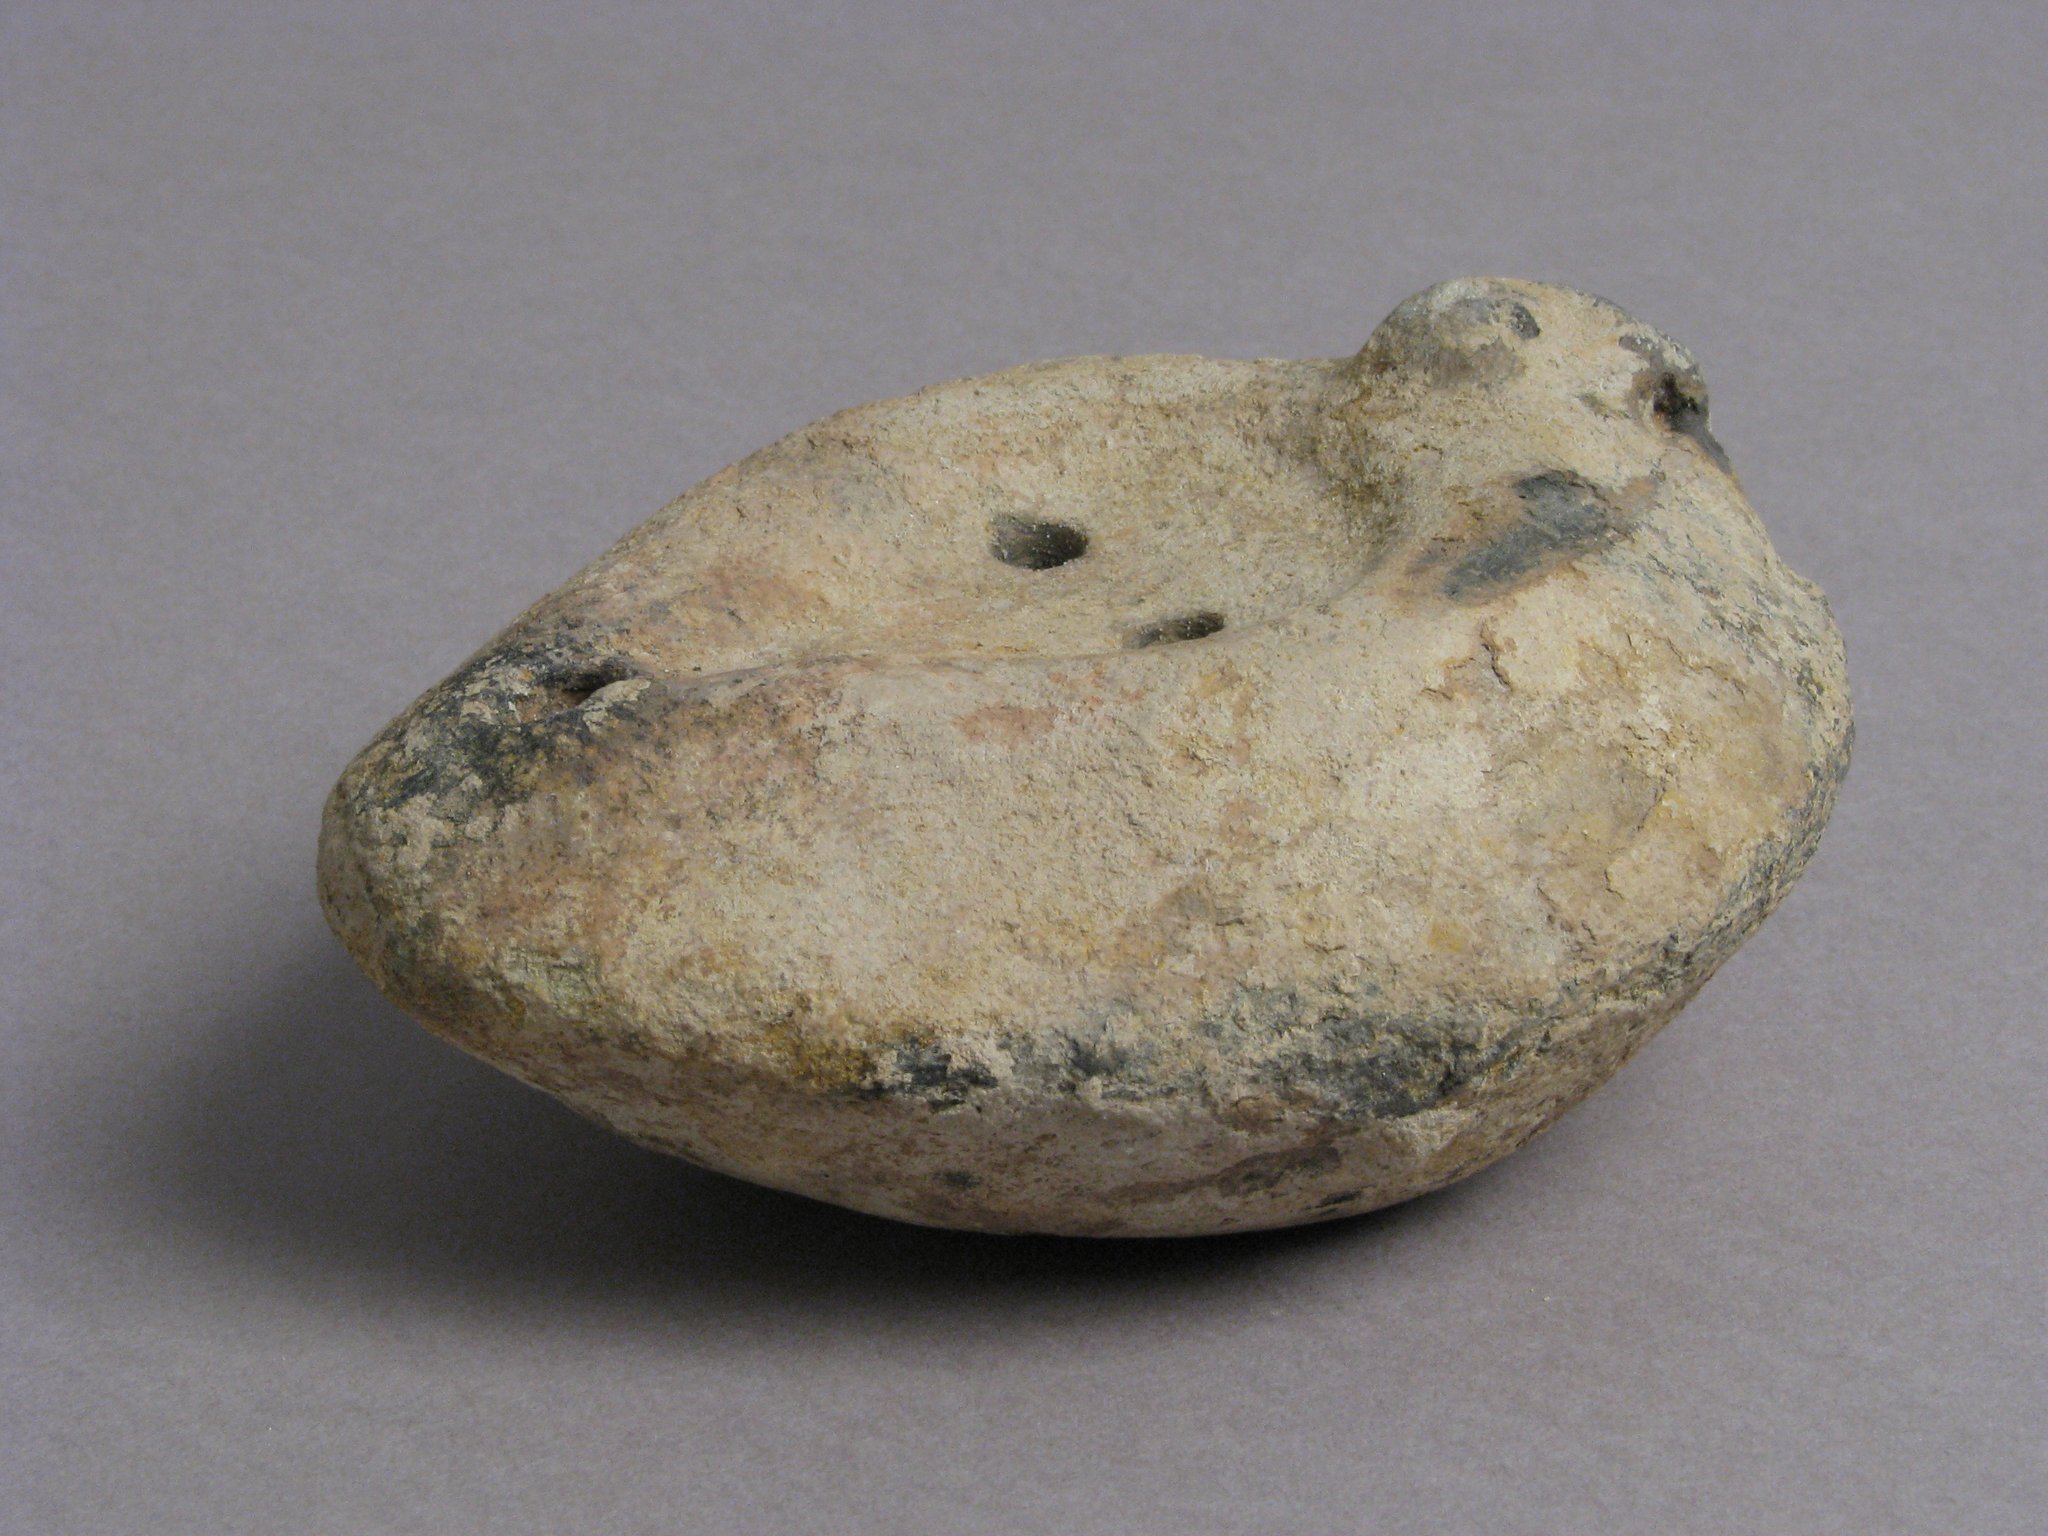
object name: lamp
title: Oil Lamp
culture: coptic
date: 301-700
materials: earthenware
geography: egypt